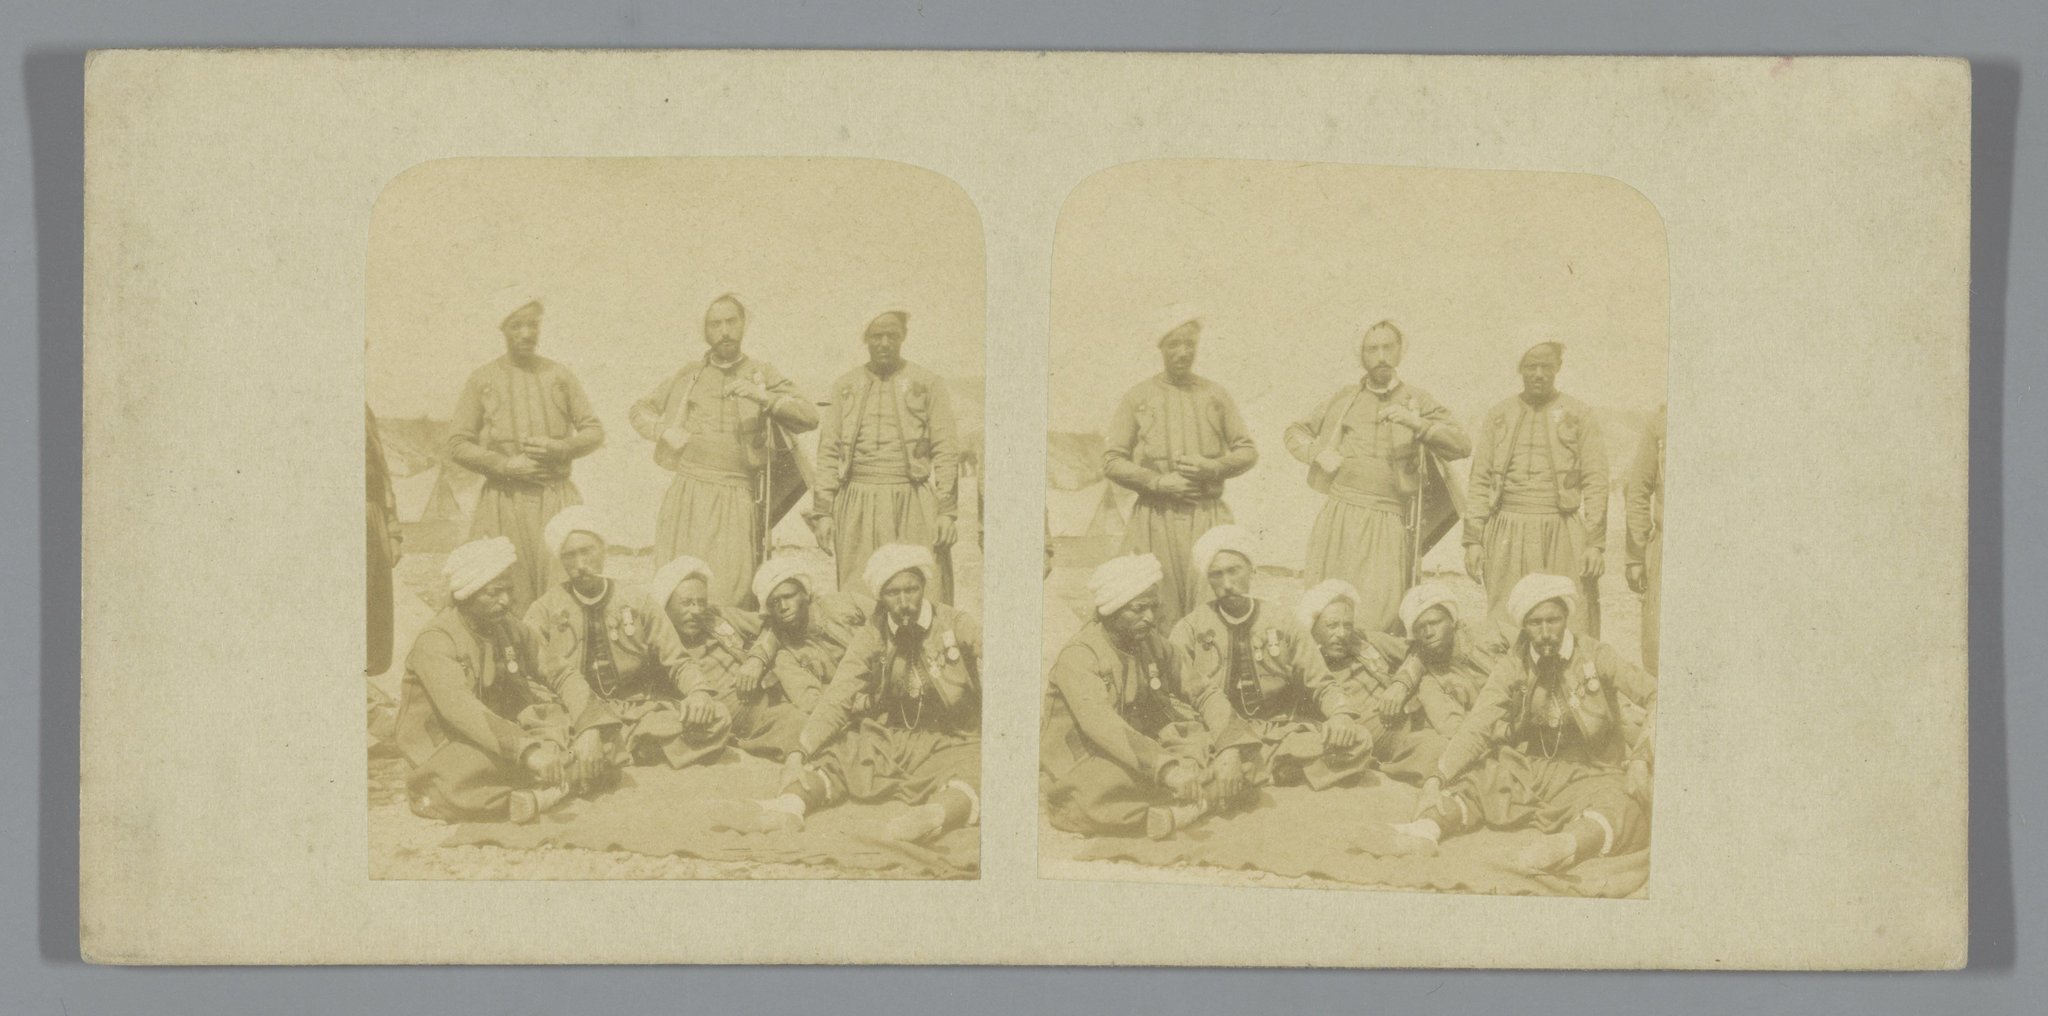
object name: stereograph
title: Zouaves at Palestro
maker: Anonymous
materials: cardboard, paper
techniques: albumen print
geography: italy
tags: the soldier; the soldier's life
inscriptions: number: ‘No. 1.’